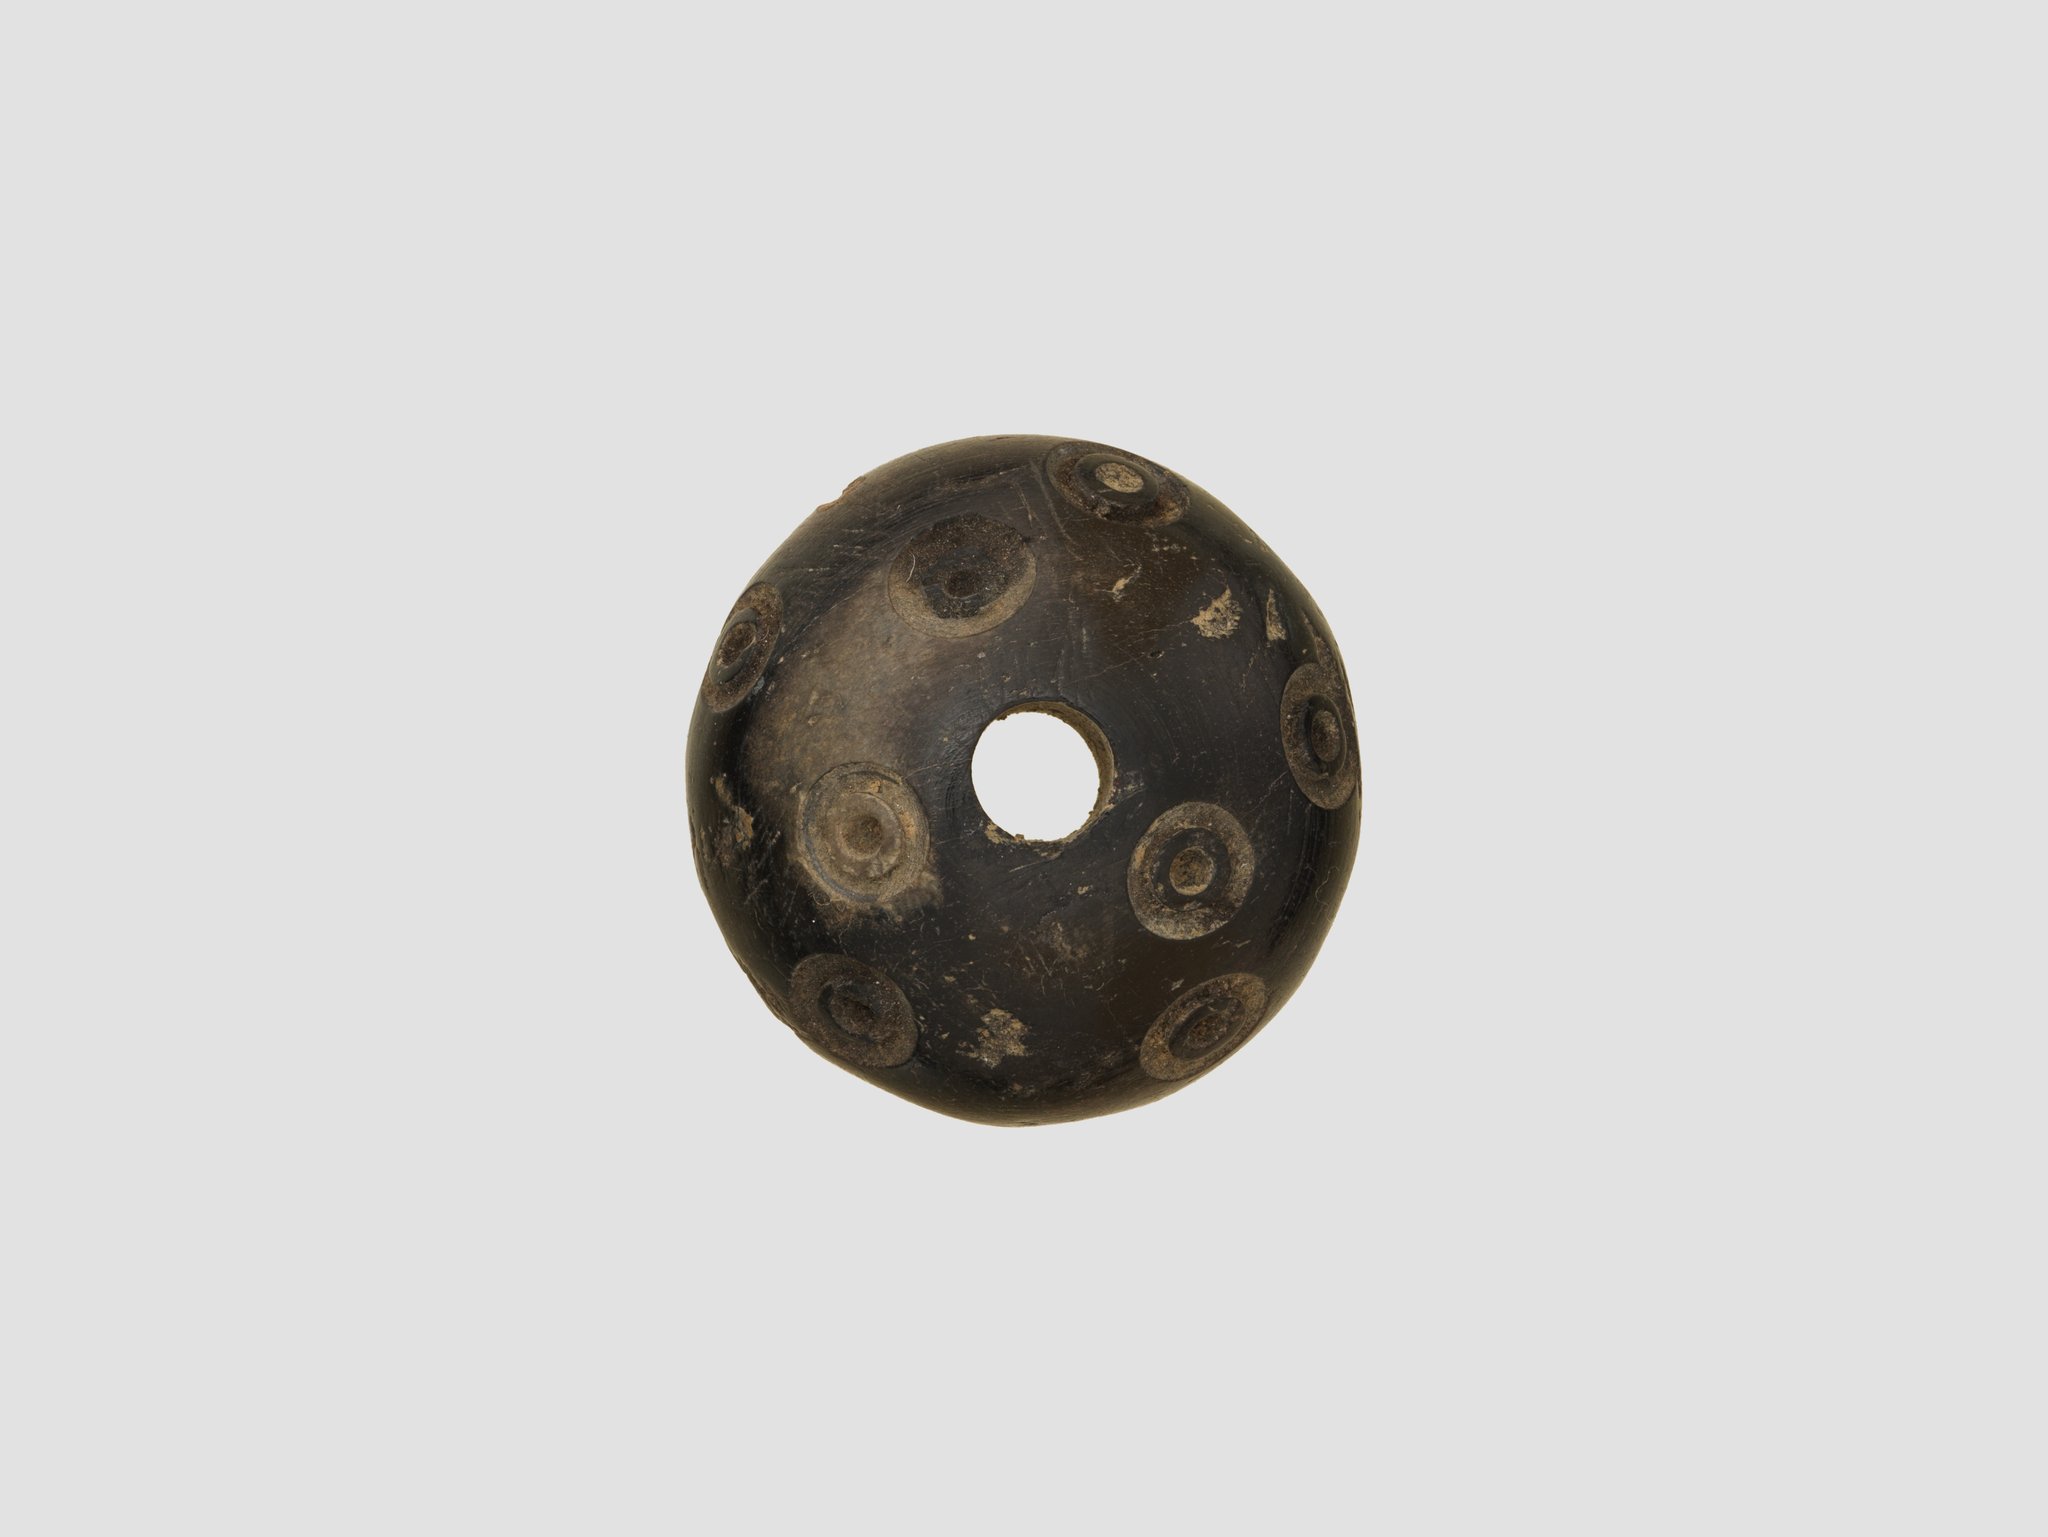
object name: bead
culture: iranian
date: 900-801 BCE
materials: bone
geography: iran